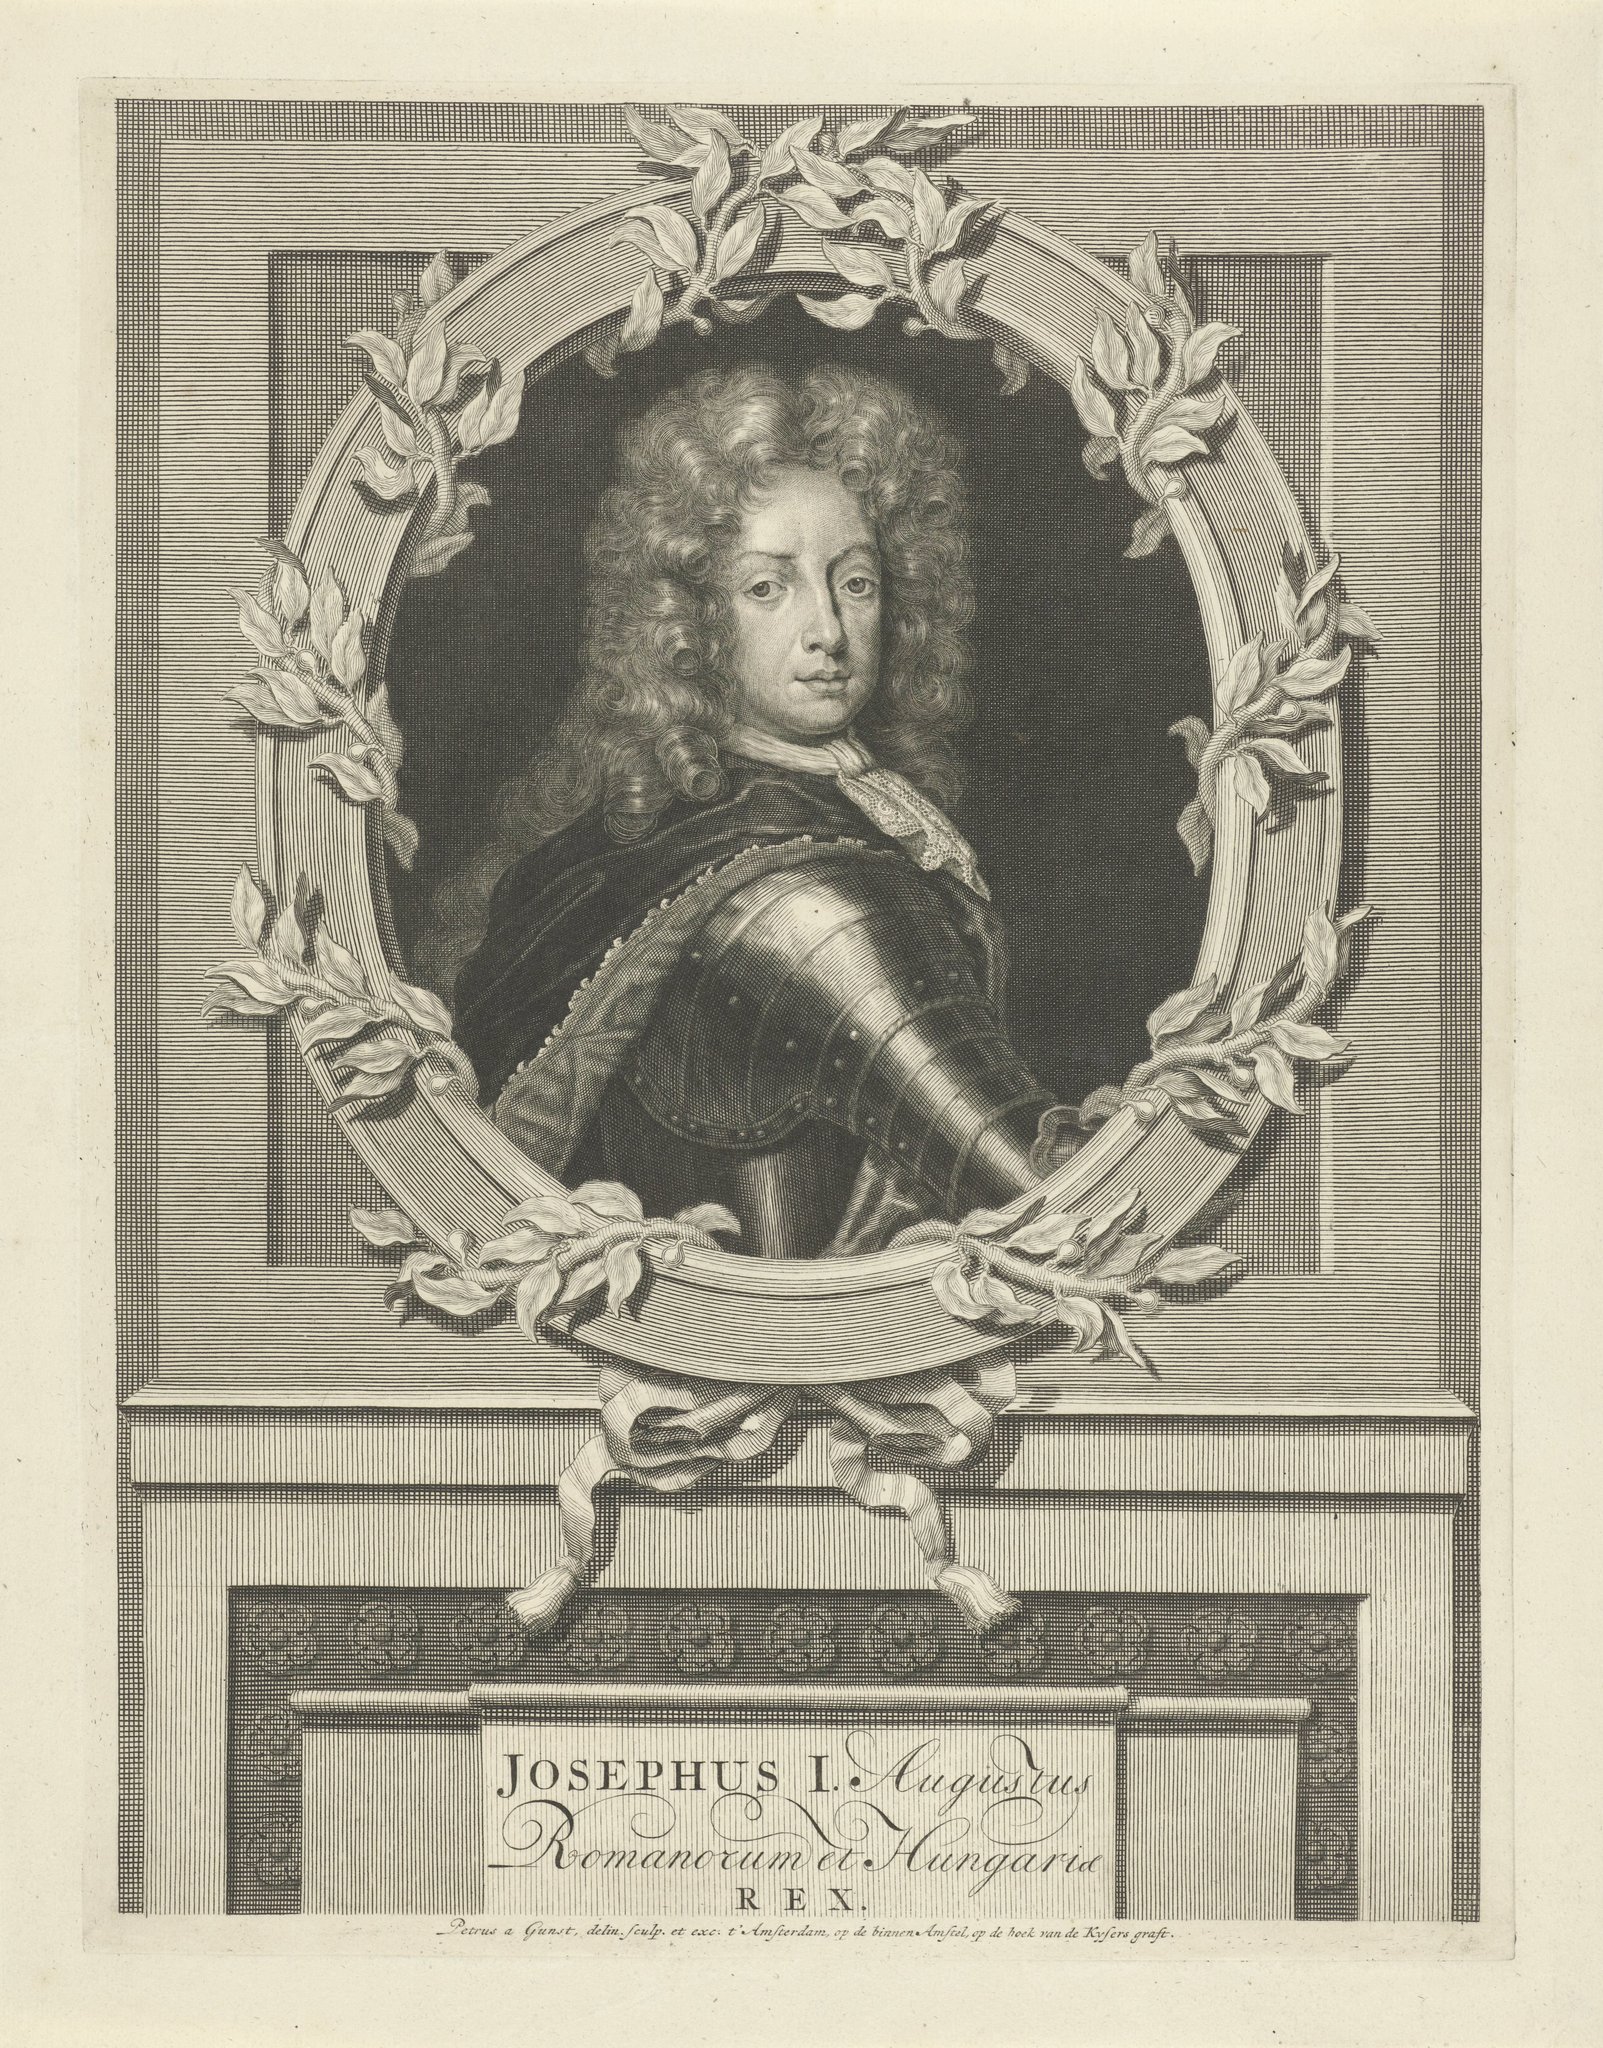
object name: print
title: Portret van keizer Jozef I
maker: pieter van gunst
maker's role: print maker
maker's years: 1658-1731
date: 1690-1731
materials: paper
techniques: engraving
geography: amsterdam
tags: vienna, jozef i (duits keizer)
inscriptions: collector's mark: Lugt 2228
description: Jozef I, keizer van het Heilig Roomse Rijk en koning van Hongarije.